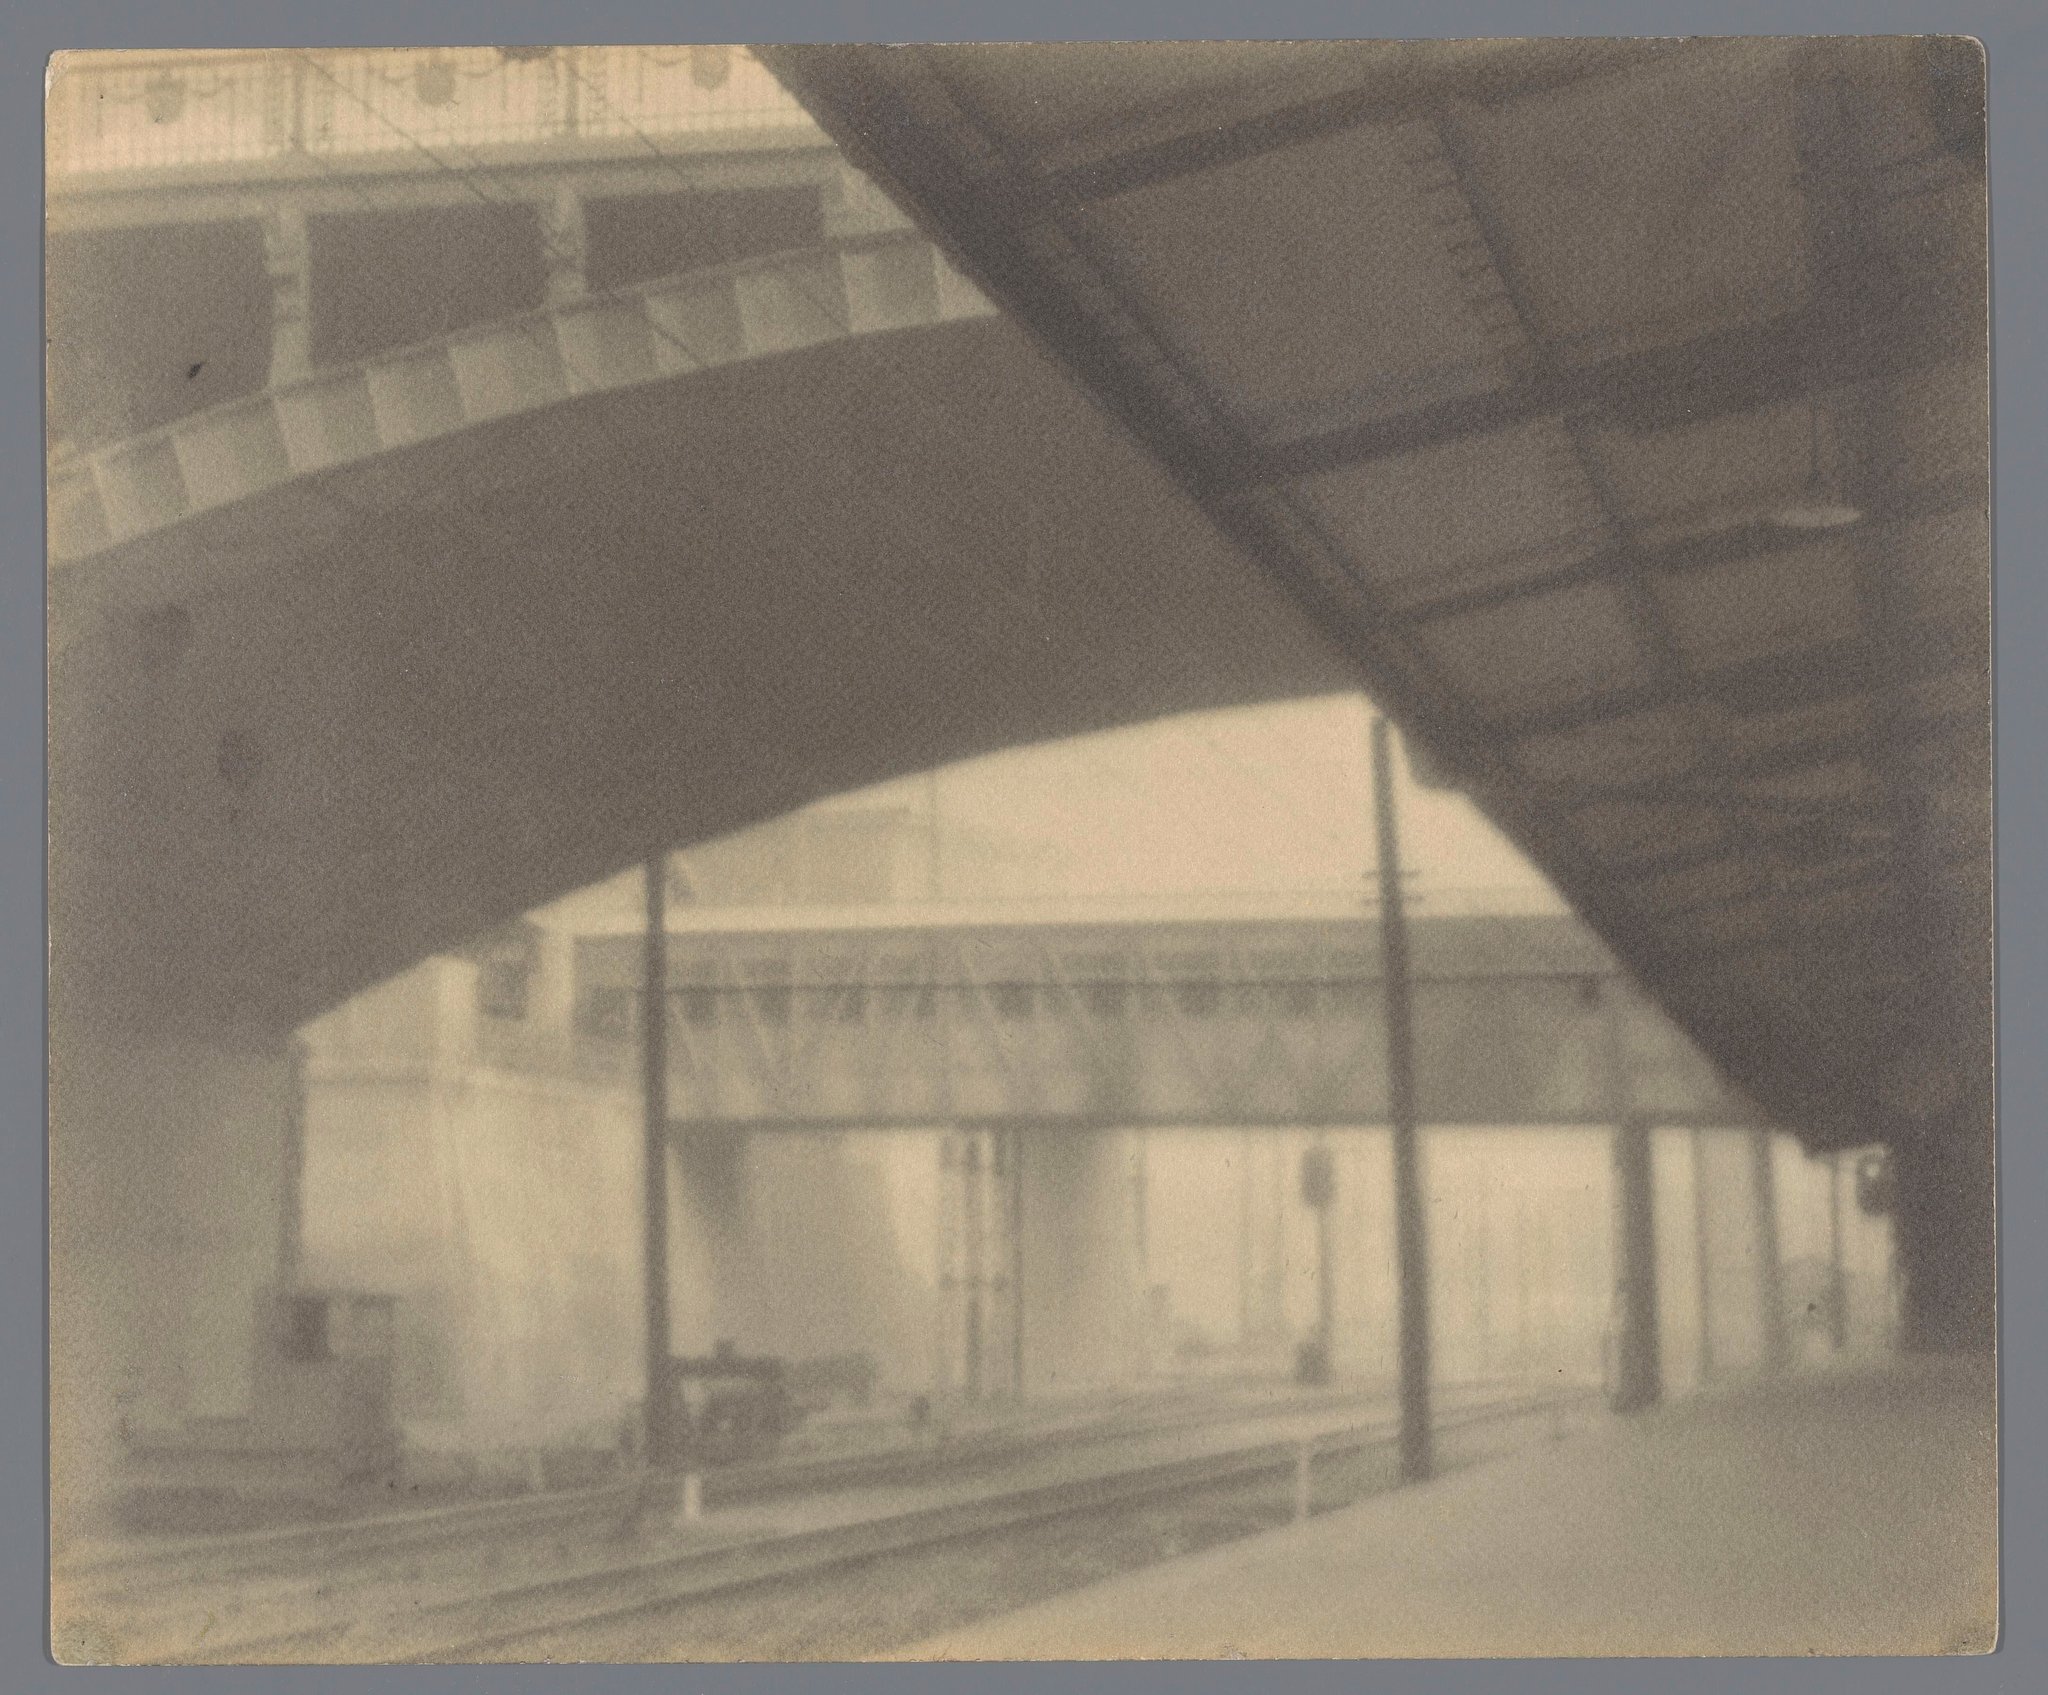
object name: photograph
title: The Tokyo Railway Depot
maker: yukio tagaki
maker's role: fotograaf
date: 1920-1930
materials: paper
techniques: bromoil process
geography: tokyo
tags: station; shelter (railway, tramway)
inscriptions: number: ‘PF48307JV CS 7049’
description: Just as elsewhere, Pictorialism in photography also became fashionable in Japan at the end of the 19th century. Pictorialists, such as Yukio Tagaki, championed photography as an independent art form, and were inspired stylistically by a painterly approach, manipulating their work with paintbrushes and paint in the darkroom. While the subject of this photograph is entirely modern, Tagaki primarily emphasized the image’s atmospheric quality.